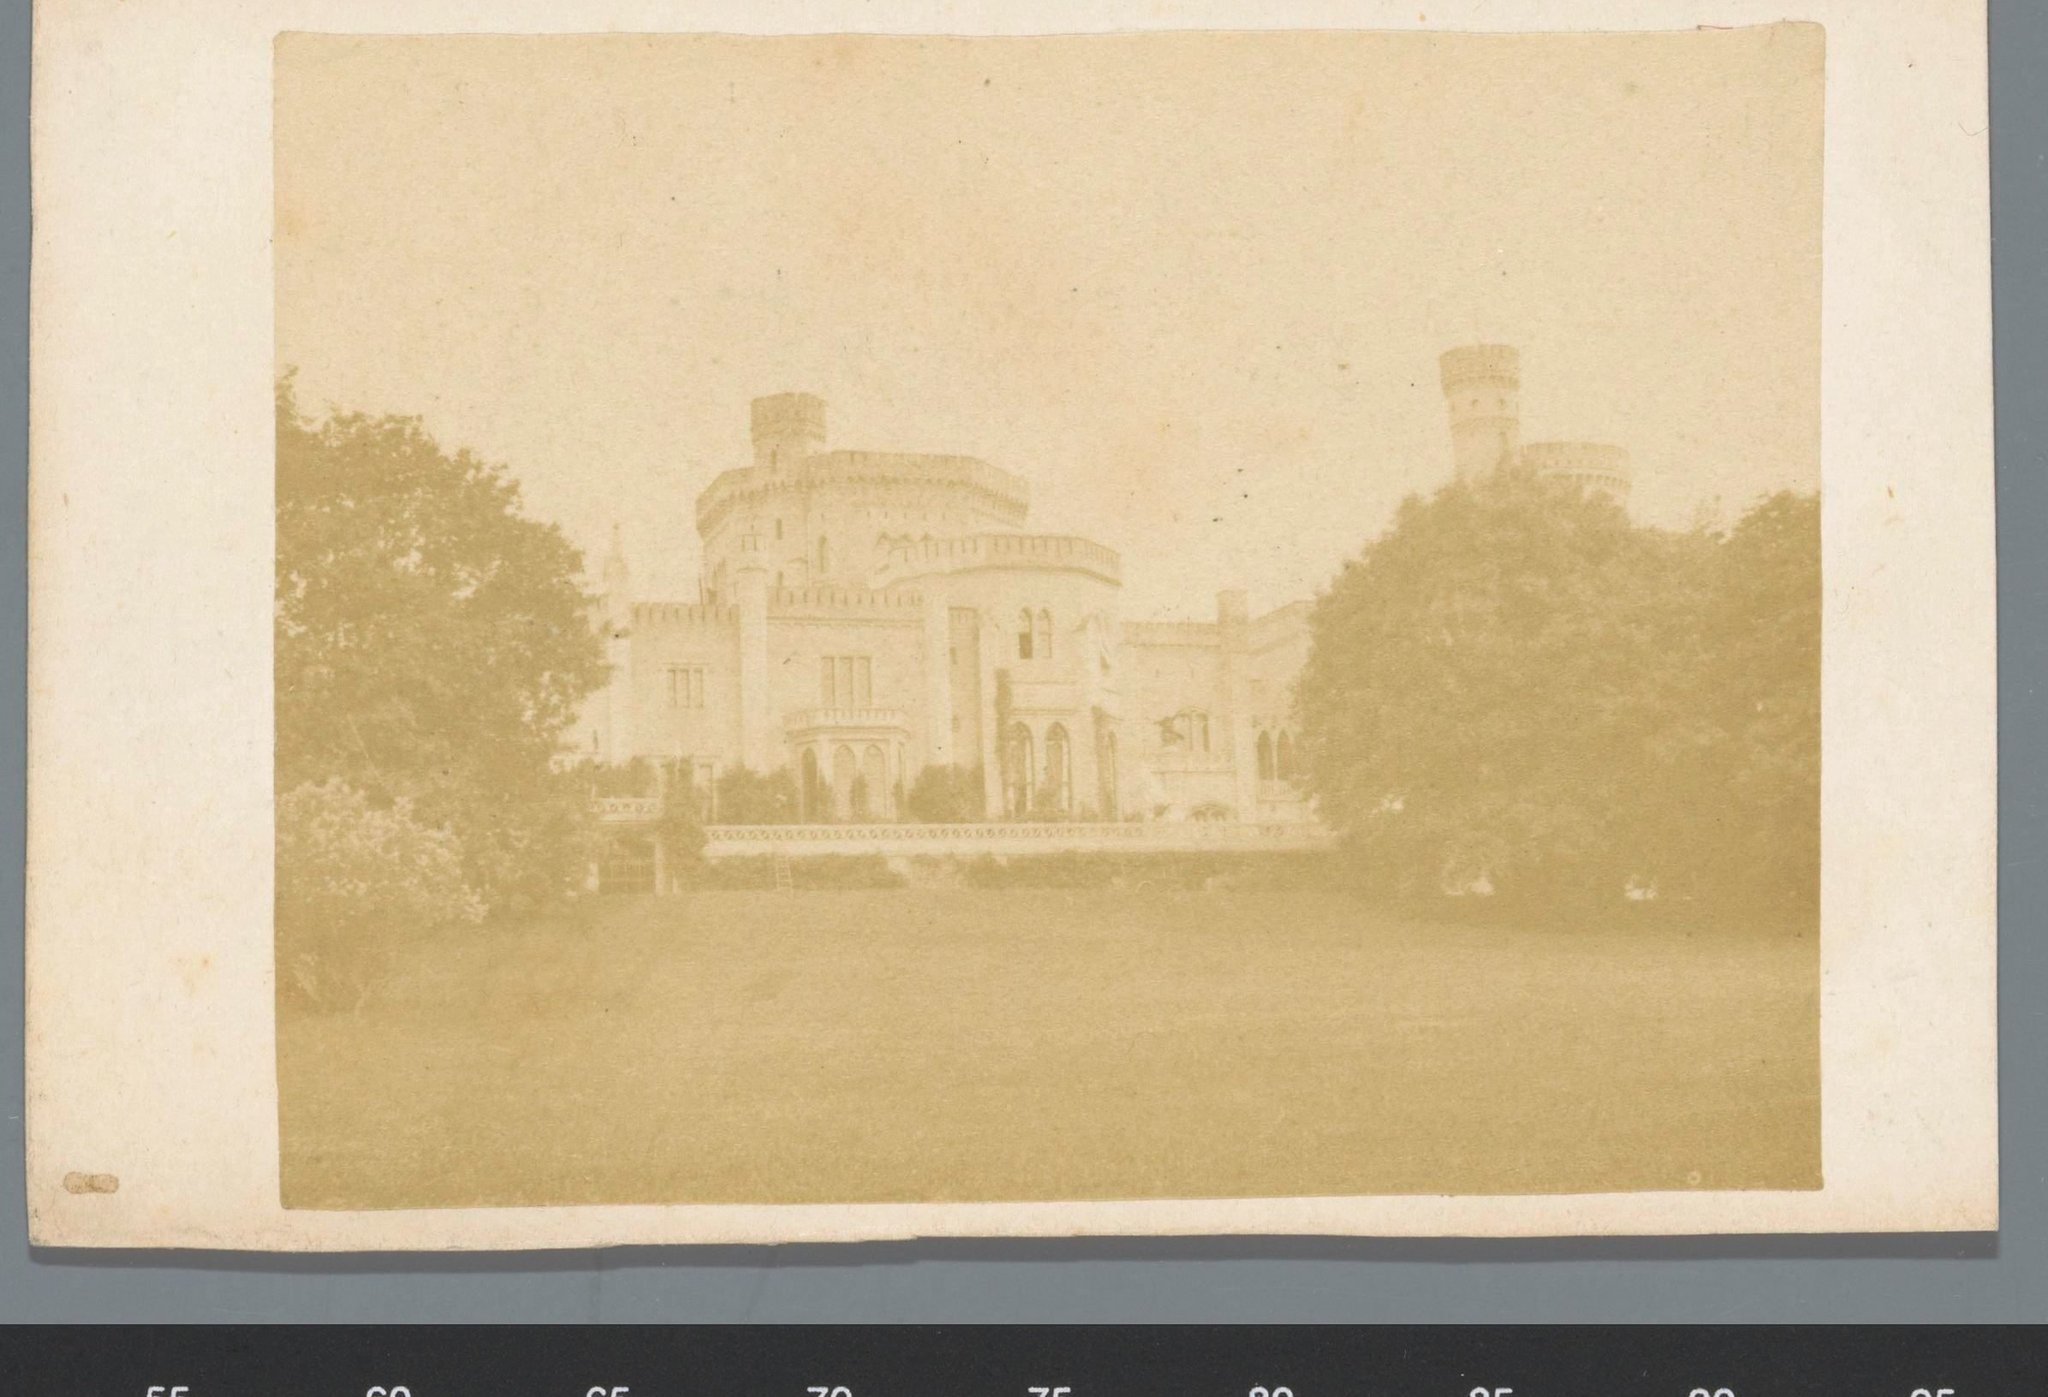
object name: photograph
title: Babelsberg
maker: hugo lehmann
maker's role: fotograaf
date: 1854-1879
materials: cardboard, paper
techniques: albumen print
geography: potsdam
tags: castle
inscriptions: address: ‘Berlin/ Schlossplatz 16.’